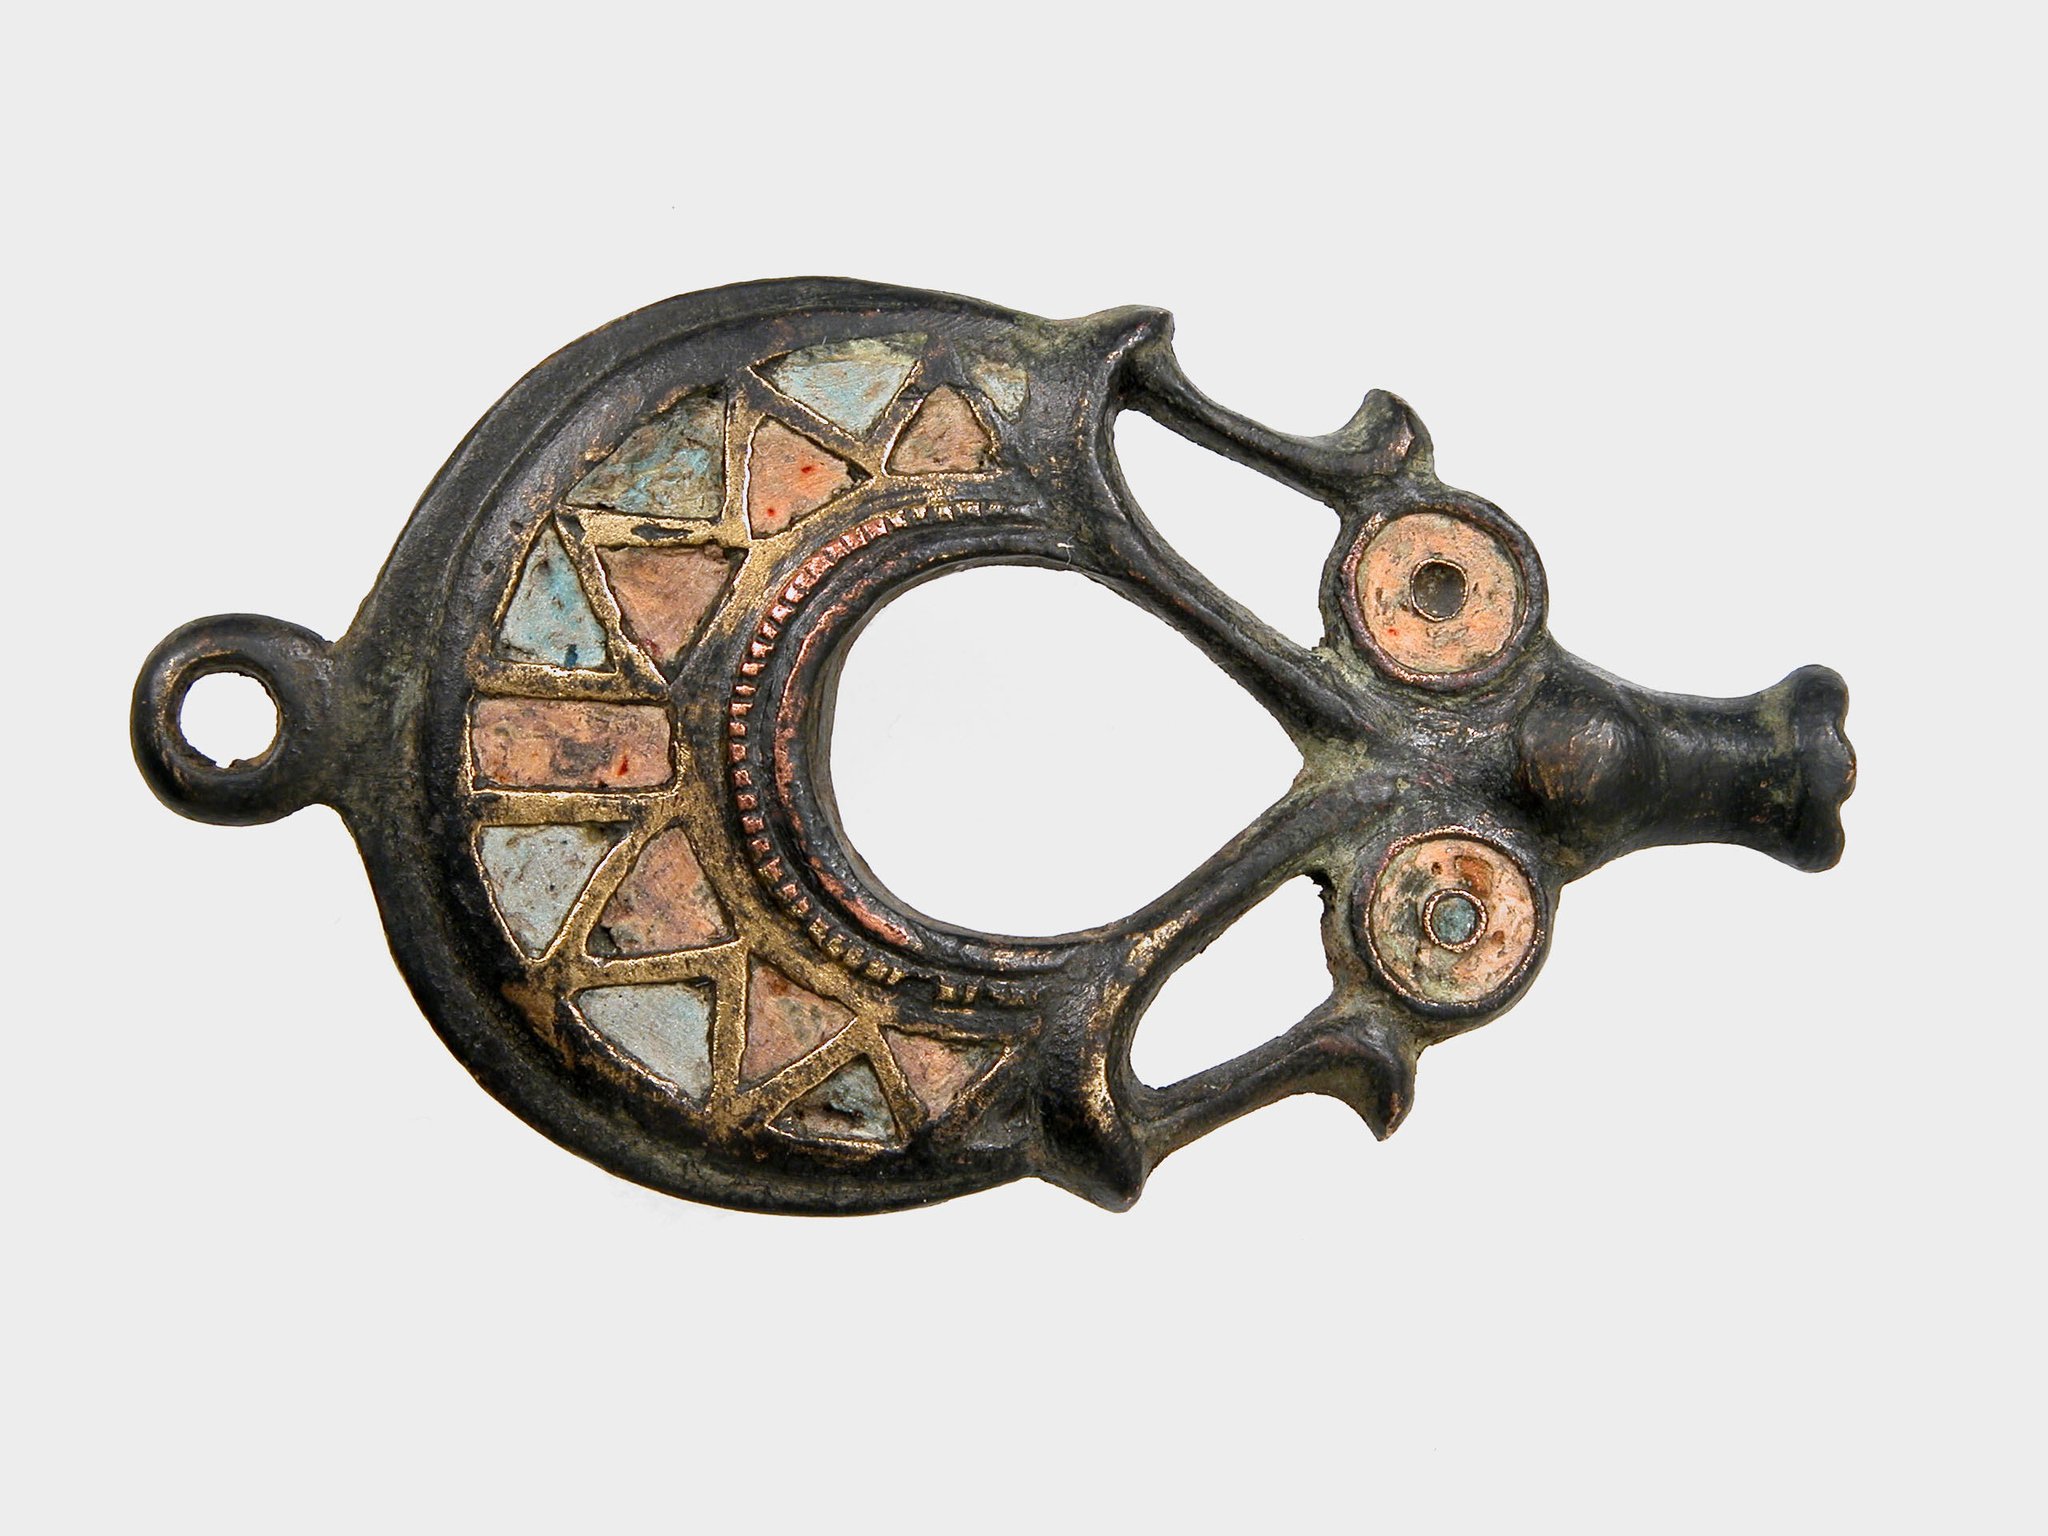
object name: brooch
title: Zoomorphic Brooch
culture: roman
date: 100-300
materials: copper alloy, enamel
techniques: enamel